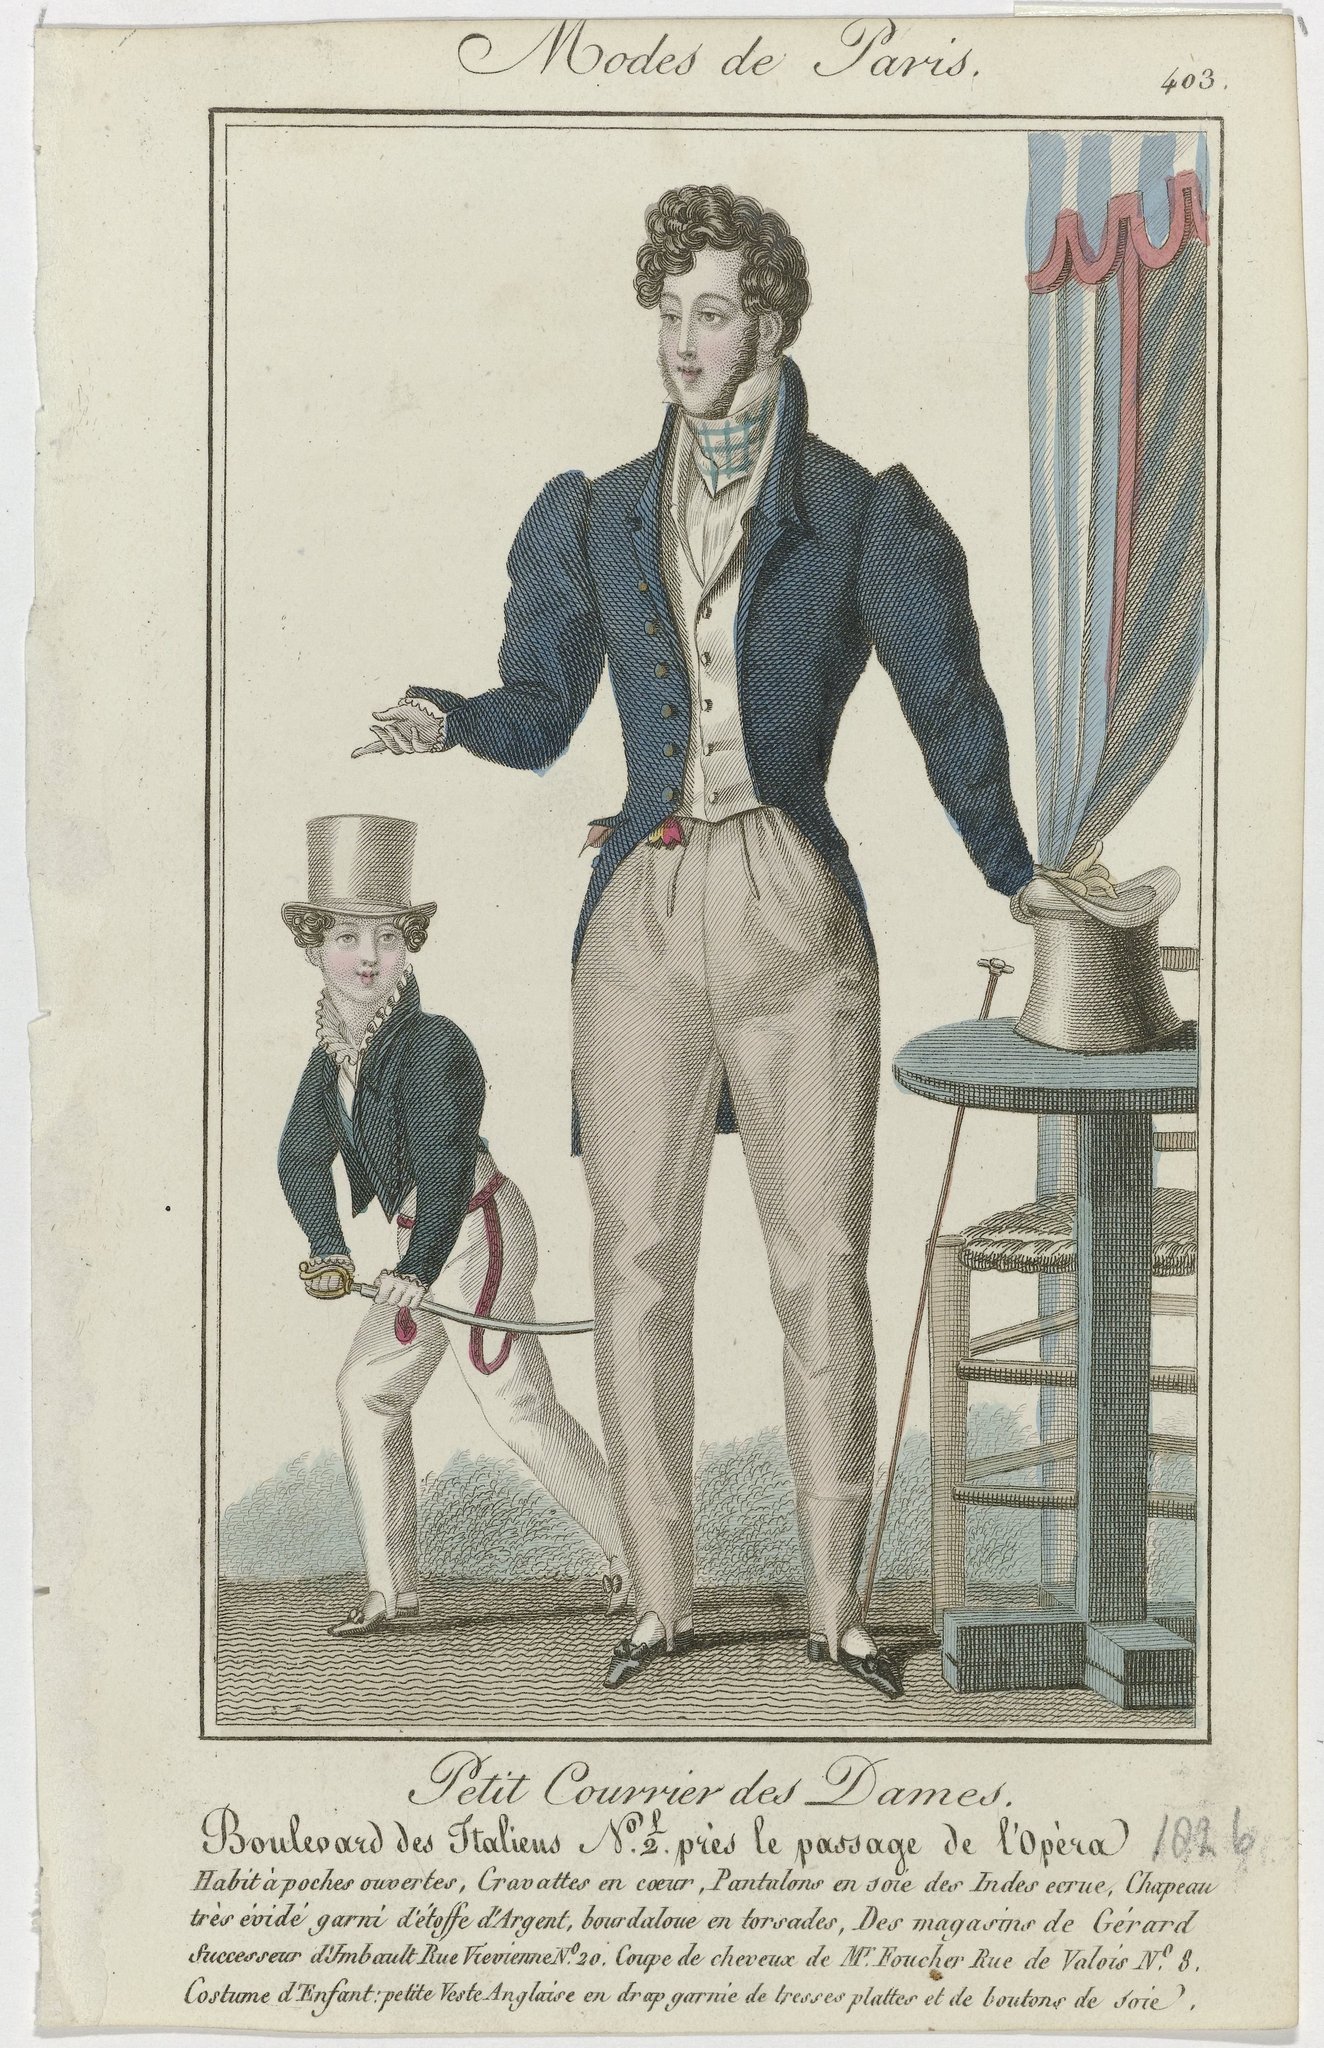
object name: fashion print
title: Petit Courrier des Dames, 1826, No. 403 : Habit à poches ouvertes (...)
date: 1826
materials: paper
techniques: engraving, hand coloring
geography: paris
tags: clothing for the upper part of the body (vest) (+ men's clothes), neck-gear ~ clothing (+ men's clothes), trousers, breeches (+ boys' clothes), trousers, breeches, etc. (pantalon) (+ men's clothes), clothing for the upper part of the body (+ boys' clothes), head-gear (+ boys' clothes), coat (+ men's clothes), fashion plates, shoes, sandals (+ men's clothes), gloves, mittens, etc. (+ men's clothes), walking-stick, staff, cane (+ men's clothes)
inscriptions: address: ‘Boulevard des Italiens No.2 près le passage de l'Opera’, title: ‘Petit Courrier des Dames.’, caption: ‘Habit à poches ouvertes, Cravattes en coeur, Pantalons en soie des Indes ecrue, Chapeau très évidé garni d'étoffe d'Argent, bourdaloue en torsades, Des magasins de Gérard Successeur d'Imbault Rue Vievienne No. 20. Coupe de cheveux de Mr. Foucher Rue de Valois No. 8. Costume d'Enfant: petite Veste Anglaise en drap garnie de tresses plattes et de boutons de soie.’, title: ‘Modes de Paris.’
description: Man in een 'habit' met open zakken, vest en spanbroek van ecrukleurige 'soie des Indes' (zijde). Op het hoofd een hoge hoed met opstaande smalle rand versierd met zilverkleurige stof en koordvormig hoedenlint, uit de winkels van Gérard, opvolger van Imbault. Kapsel door Mr Foucher. 'Cravattes en coeur' Verdere accessoires: handschoenen, wandelstok, platte schoenen met strikken. Naast hem een jongen gekleed in een 'veste Anglaise' (jas) van laken, versierd met platte tressen en knopen van zijde. Spanbroek. Accessoires: hoge hoed, sabel aan twee afhangriemen, platte schoenen met strikken. Prent uit het modetijdschrift Petit Courrier des Dames (1821-1868).